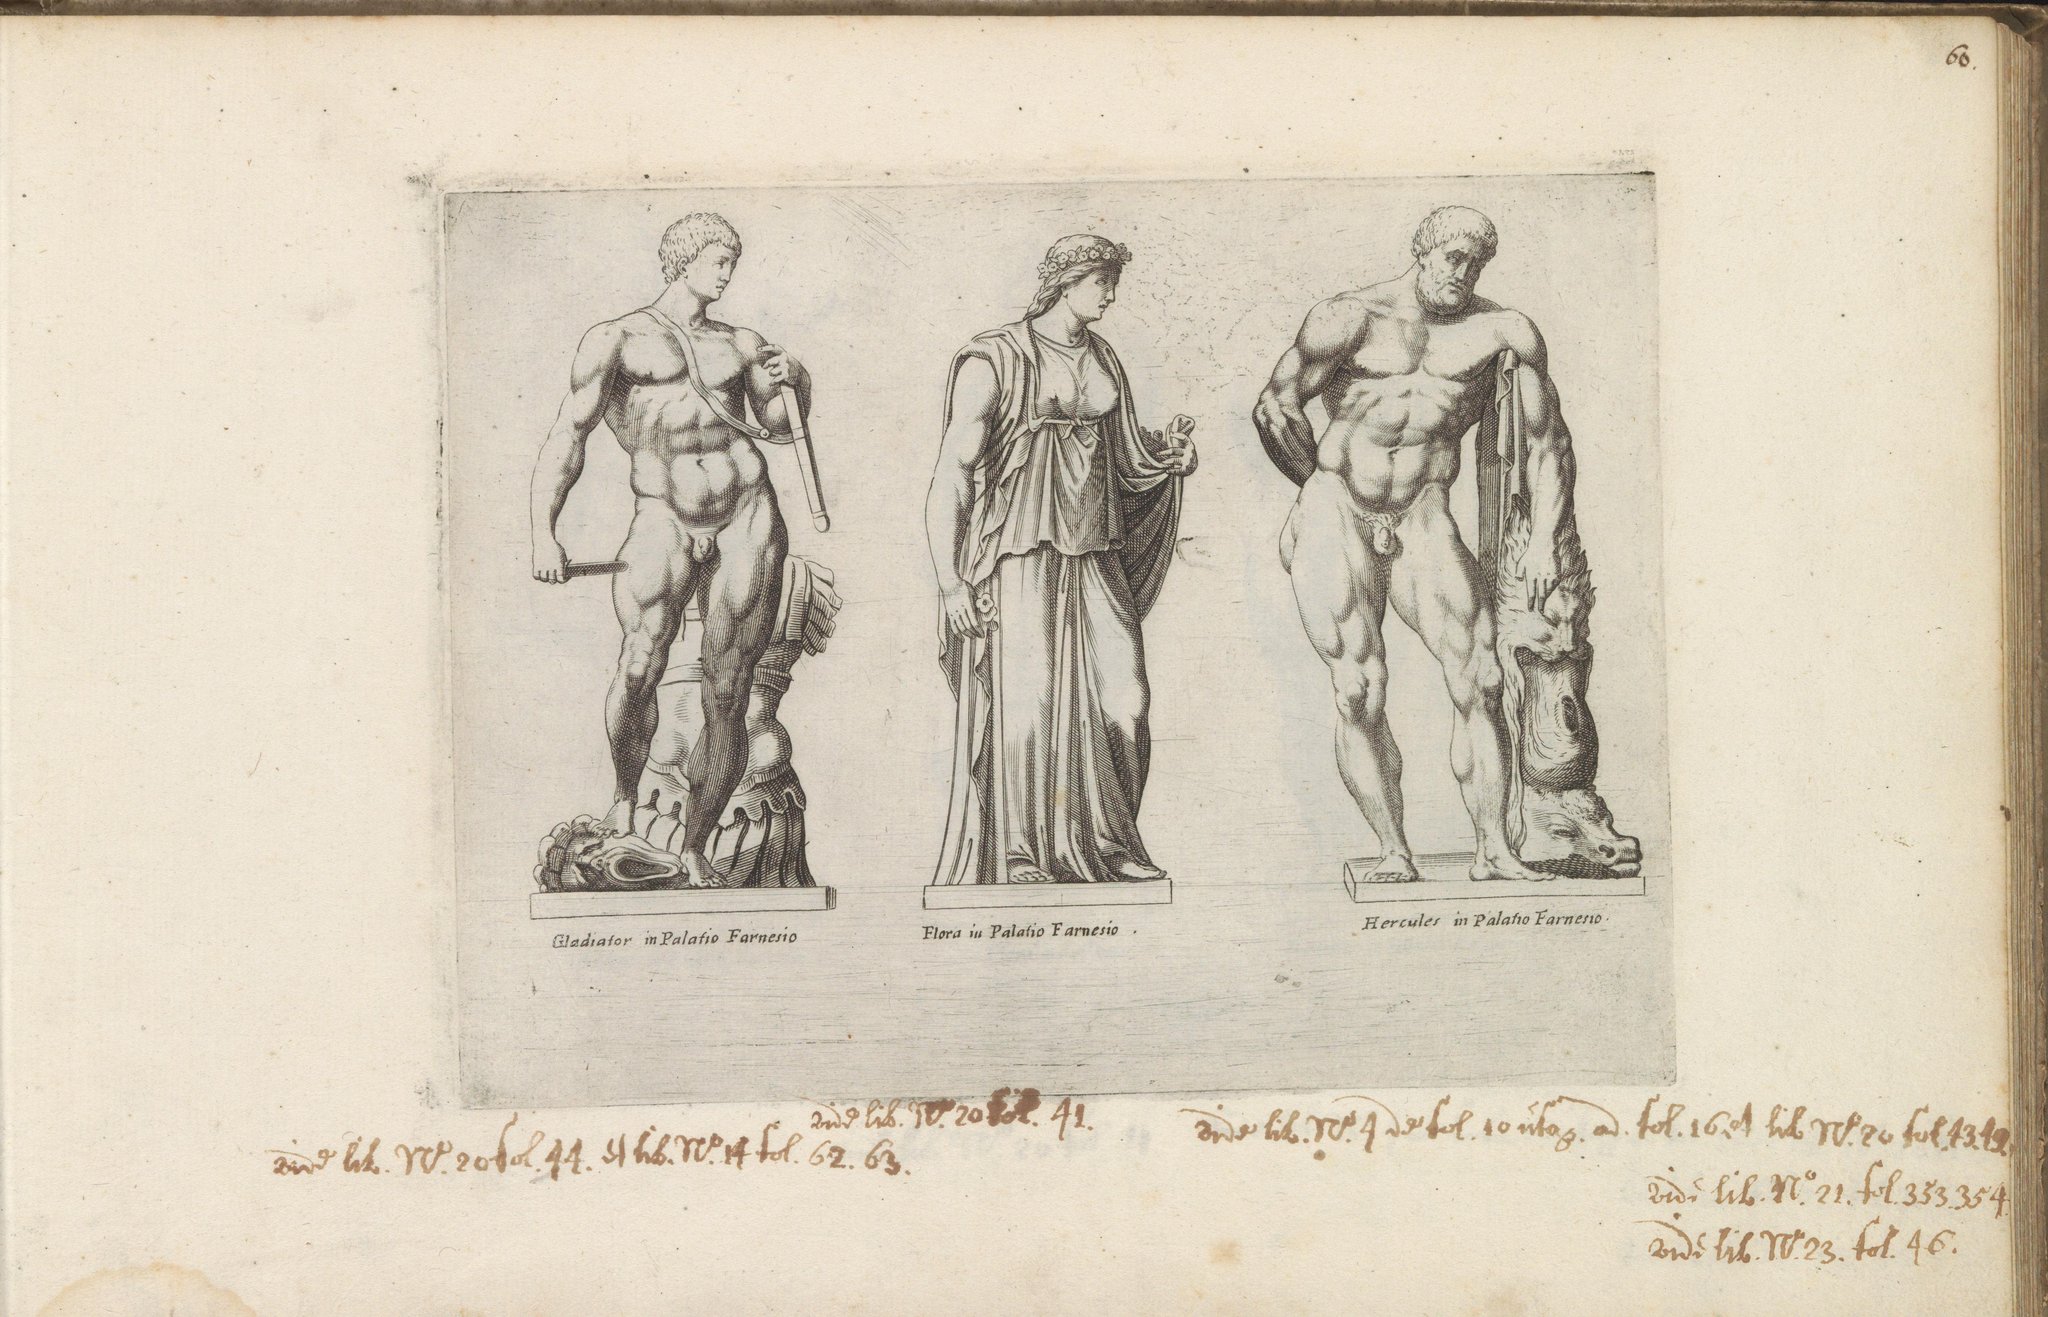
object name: album leaf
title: Sculpturen uit de oudheid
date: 1538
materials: paper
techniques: engraving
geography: italy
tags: (story of) hercules (heracles), fight of gladiators, piece of sculpture, reproduction of a piece of sculpture, (story of) flora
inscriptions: inscription: ‘Ende lib. No. 20 fol. 44. et lib. No. 14 fol. 62. 63...’, number: ‘60’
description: Deze prent maakt deel uit van een reeks van ten minste 19 prenten van sculpturen uit de oudheid. De beelden bevinden zich in Palazzo Farnese te Rome.